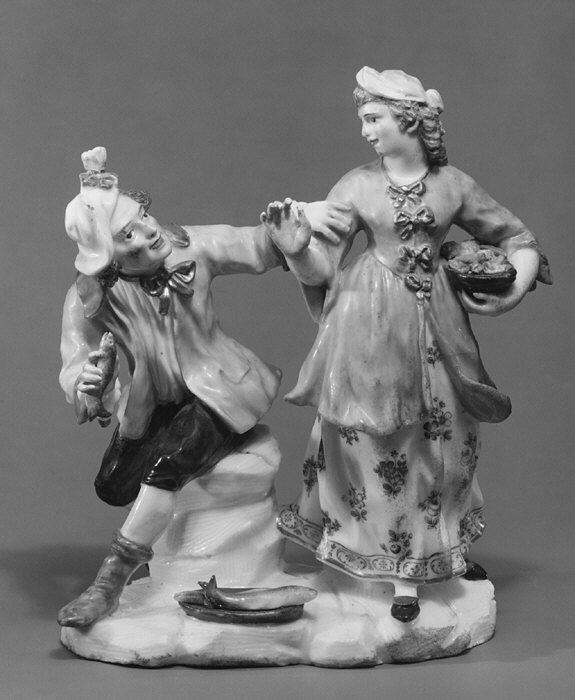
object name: group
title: Fisherman and girl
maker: capodimonte porcelain manufactory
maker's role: manufactory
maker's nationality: italian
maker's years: 1740-1759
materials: soft paste porcelain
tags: girls,men,fish